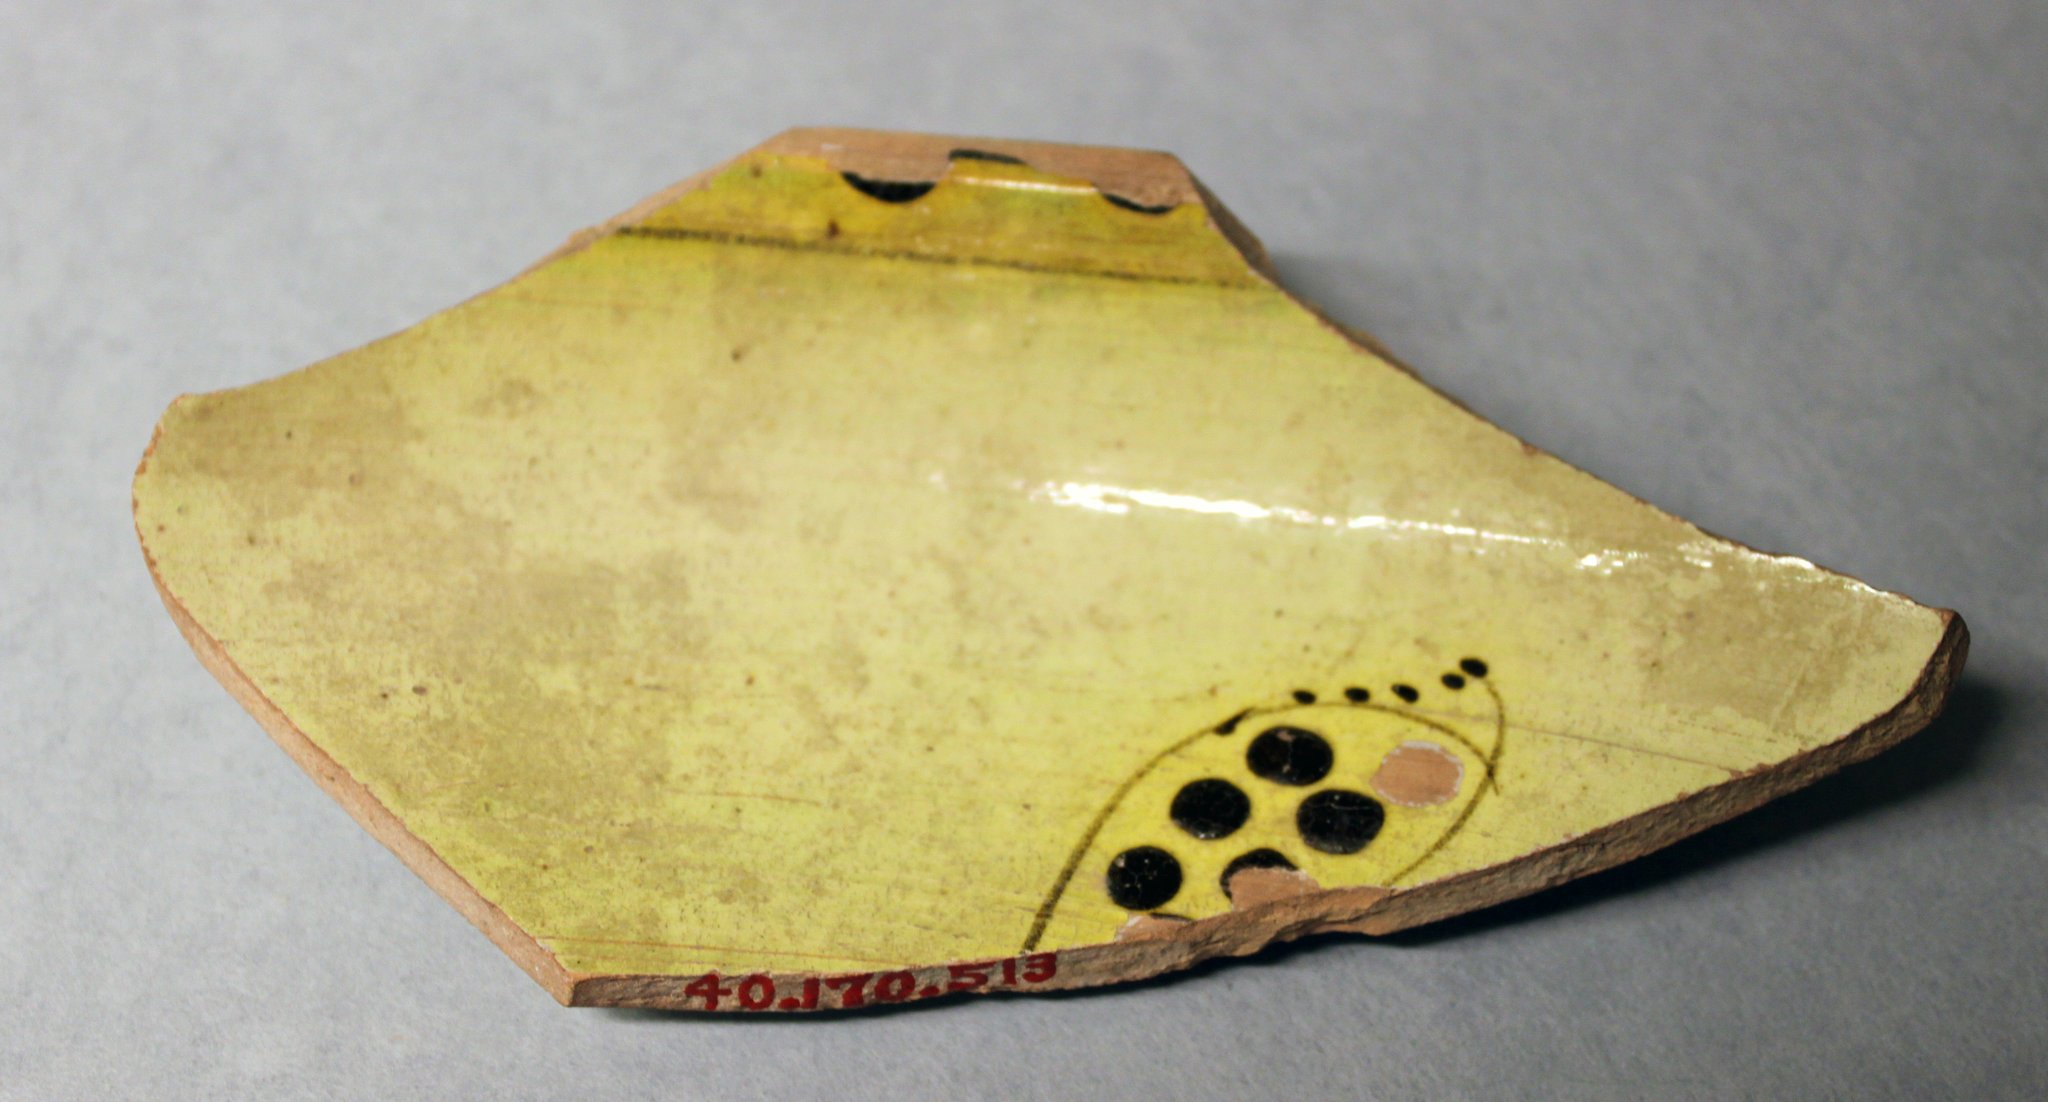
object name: fragment of a bowl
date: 901-1000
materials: earthenware, glaze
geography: iran